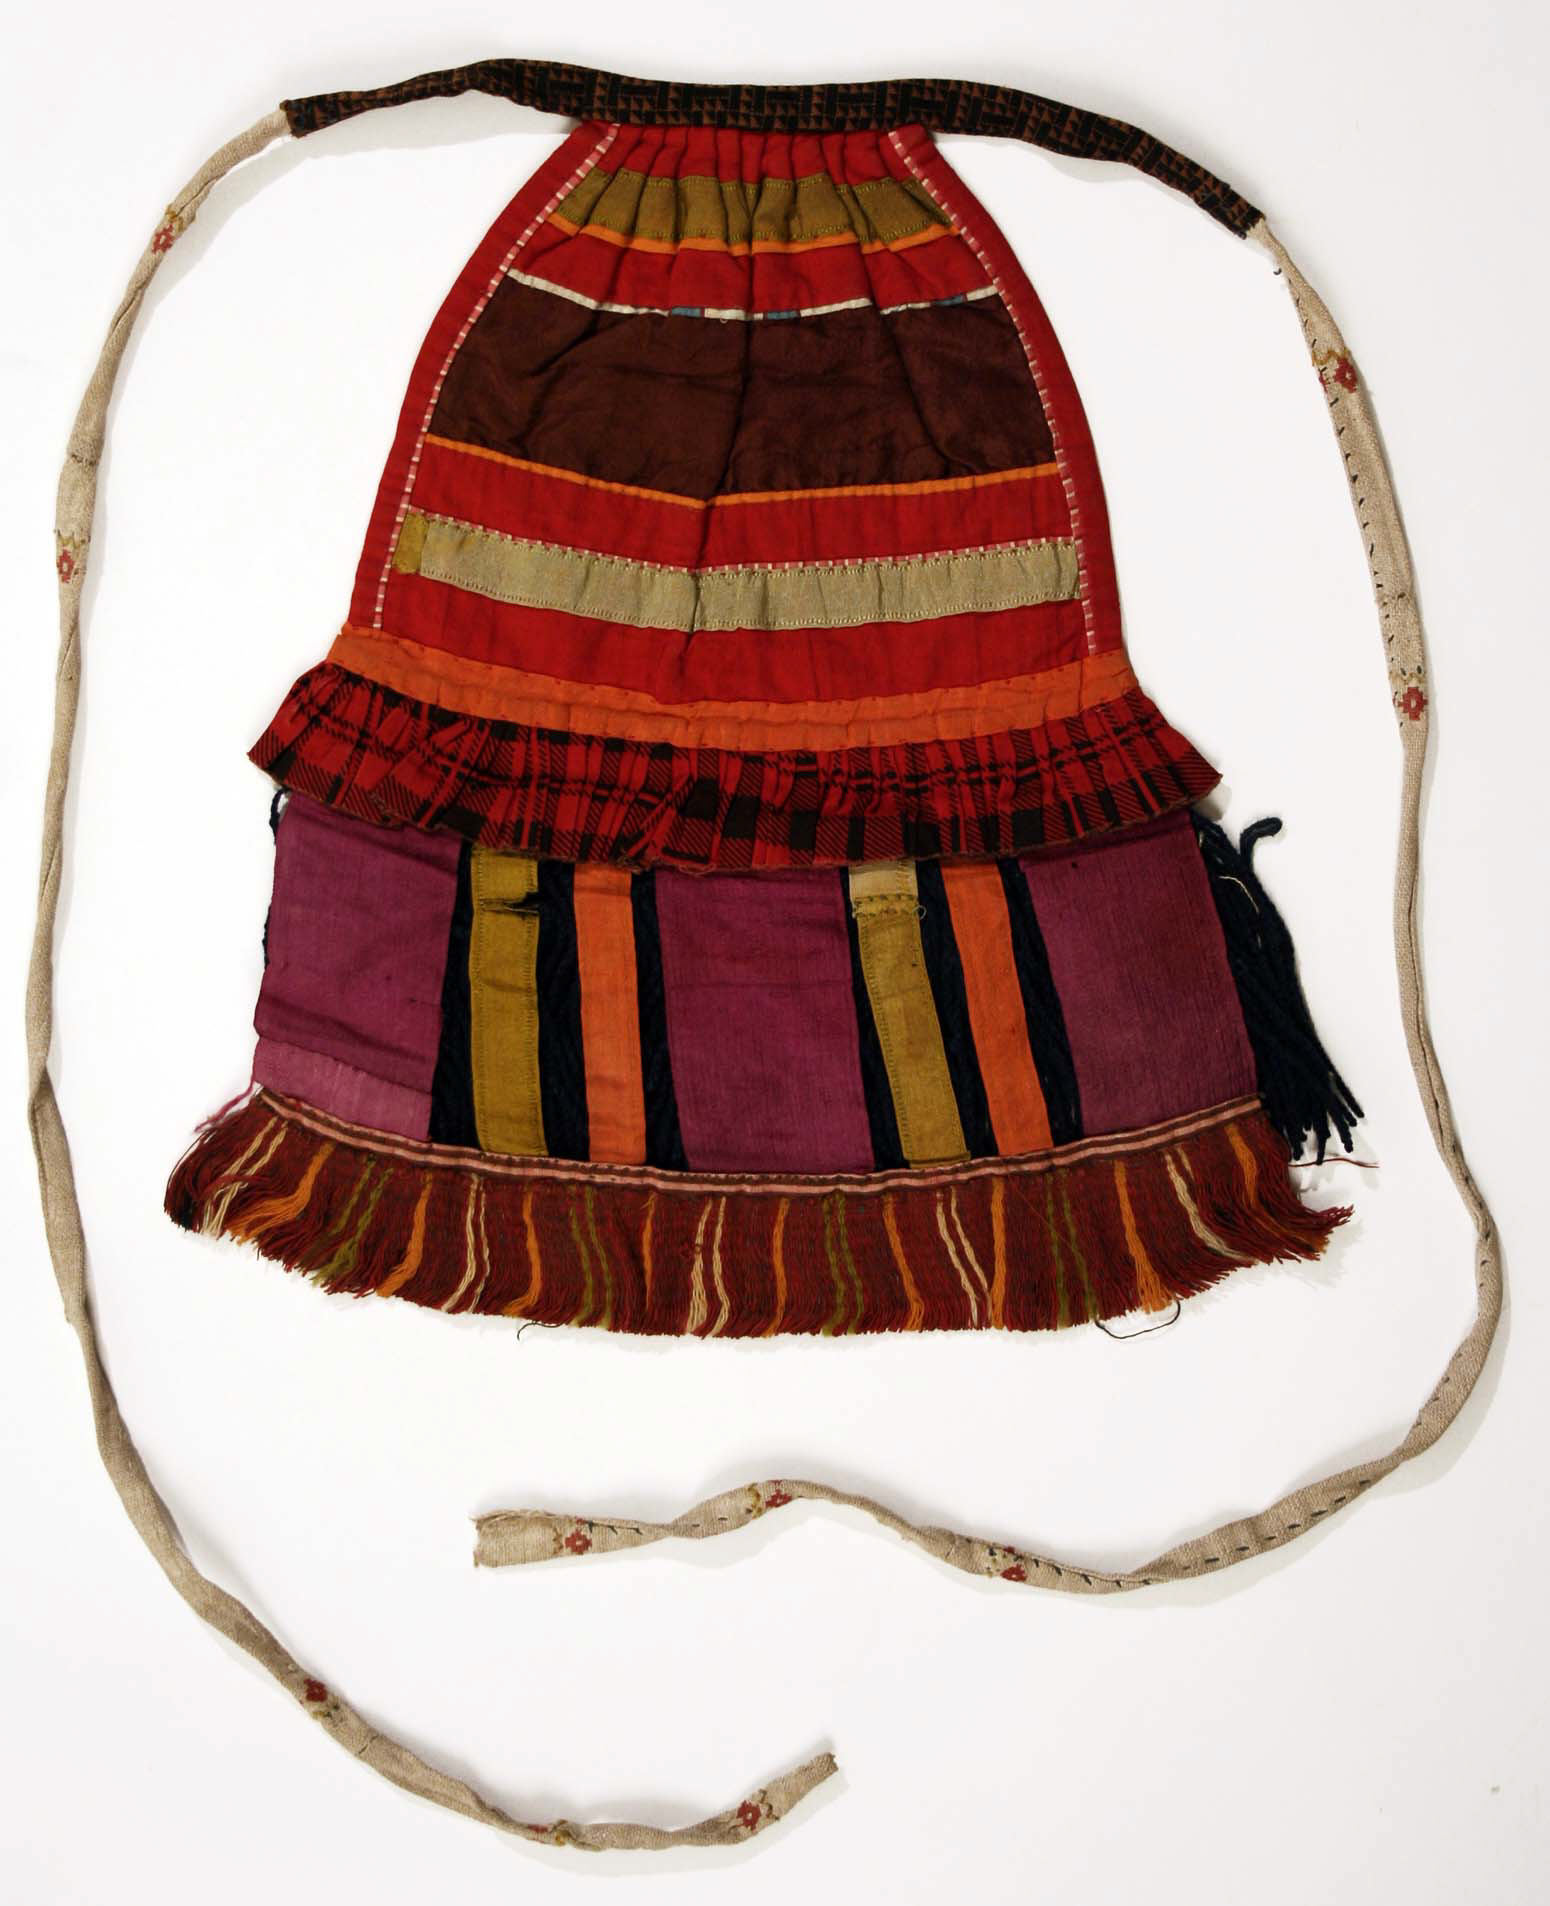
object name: pocket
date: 1801-1900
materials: cotton